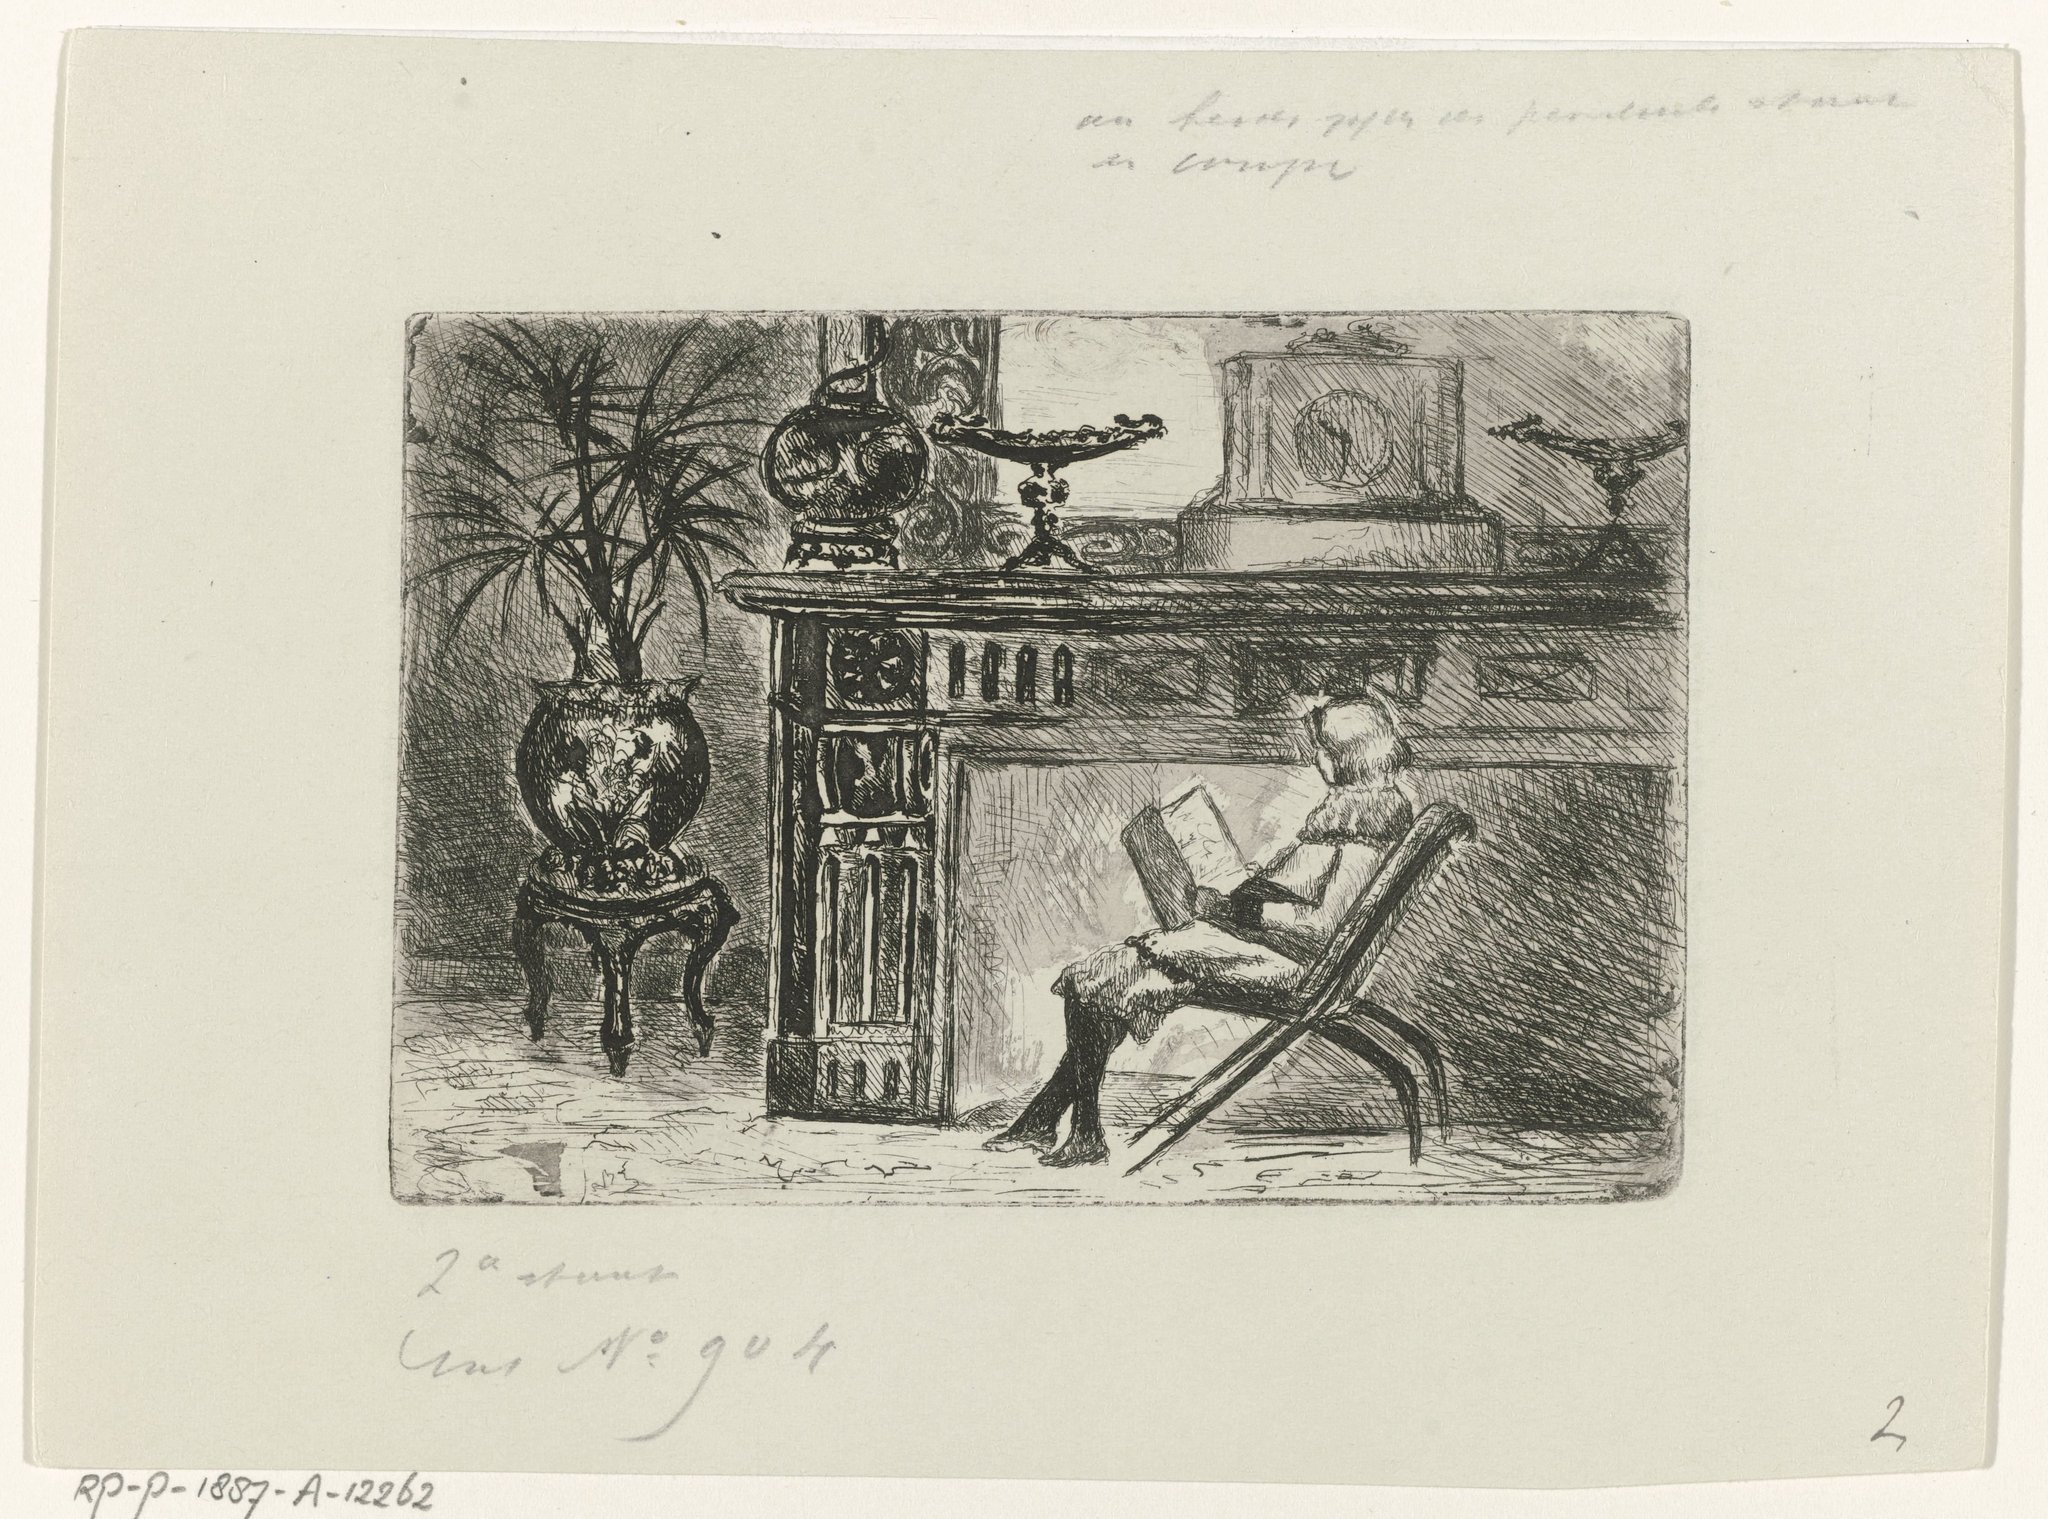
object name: print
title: Lezende man voor schoorsteen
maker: Anonymous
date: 1800-1887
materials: paper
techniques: etching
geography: netherlands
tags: chimney, reading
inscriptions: collector's mark: Lugt 2228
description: Een jongeman zit op een stoel voor een haard te lezen. Op de schoorsteenmantel een klok. Links in de kamer een plant in een pot op een tafeltje.